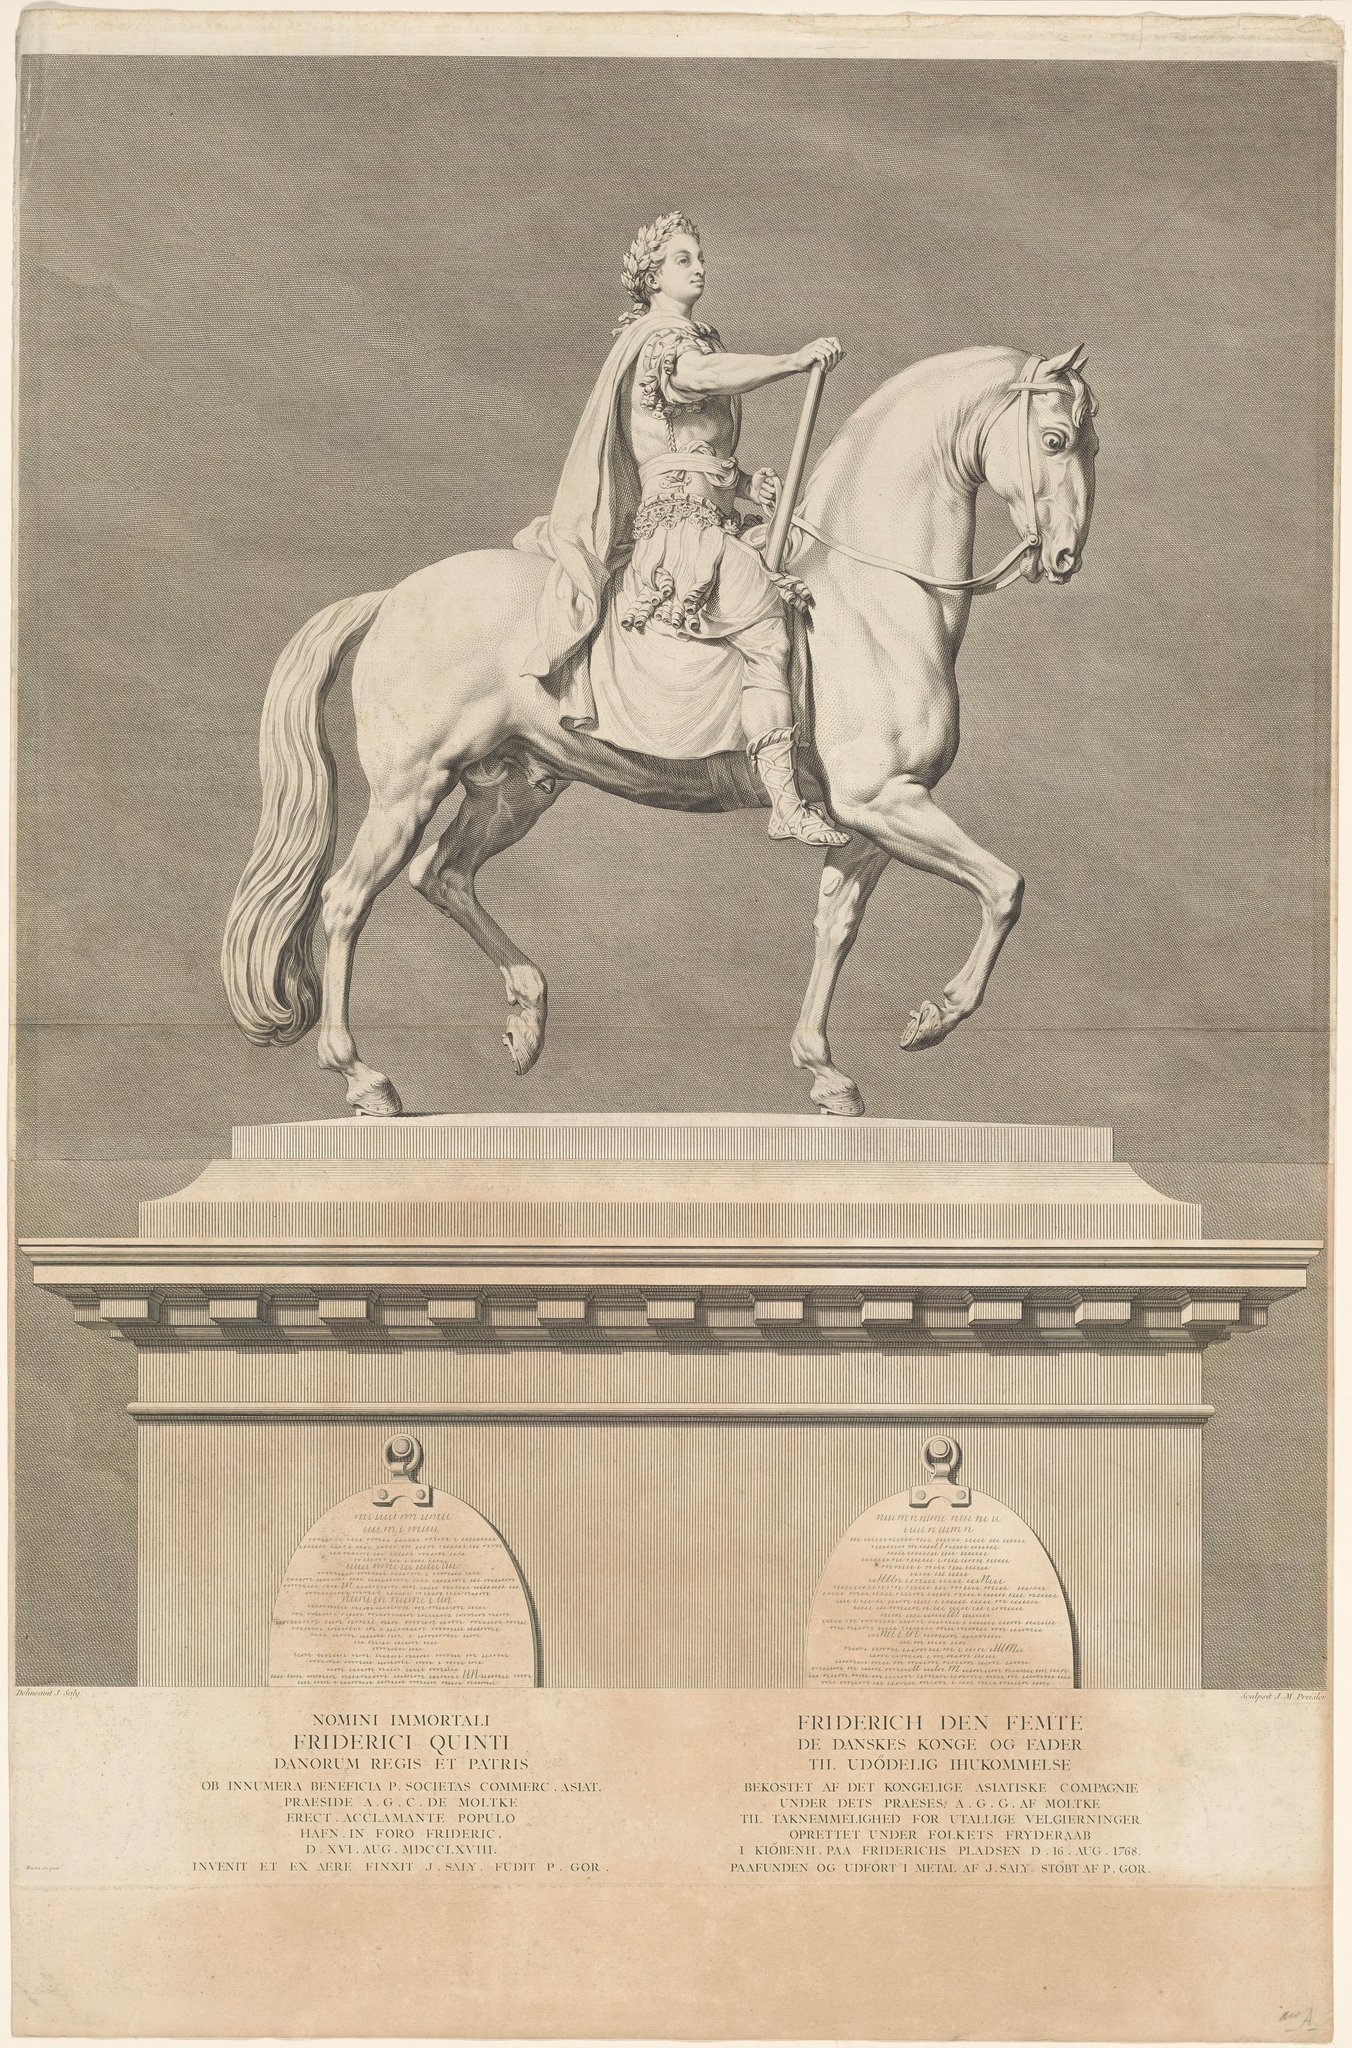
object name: print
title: Ruiterstandbeeld van Frederik V van Denemarken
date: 1768-1794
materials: paper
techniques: engraving, etching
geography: copenhagen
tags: copenhagen (city), historical persons, equestrian statue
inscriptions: collector's mark: Lugt 2228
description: Met negenregelig onderschrift in het Latijn en Duits, verdeeld in twee kolommen.